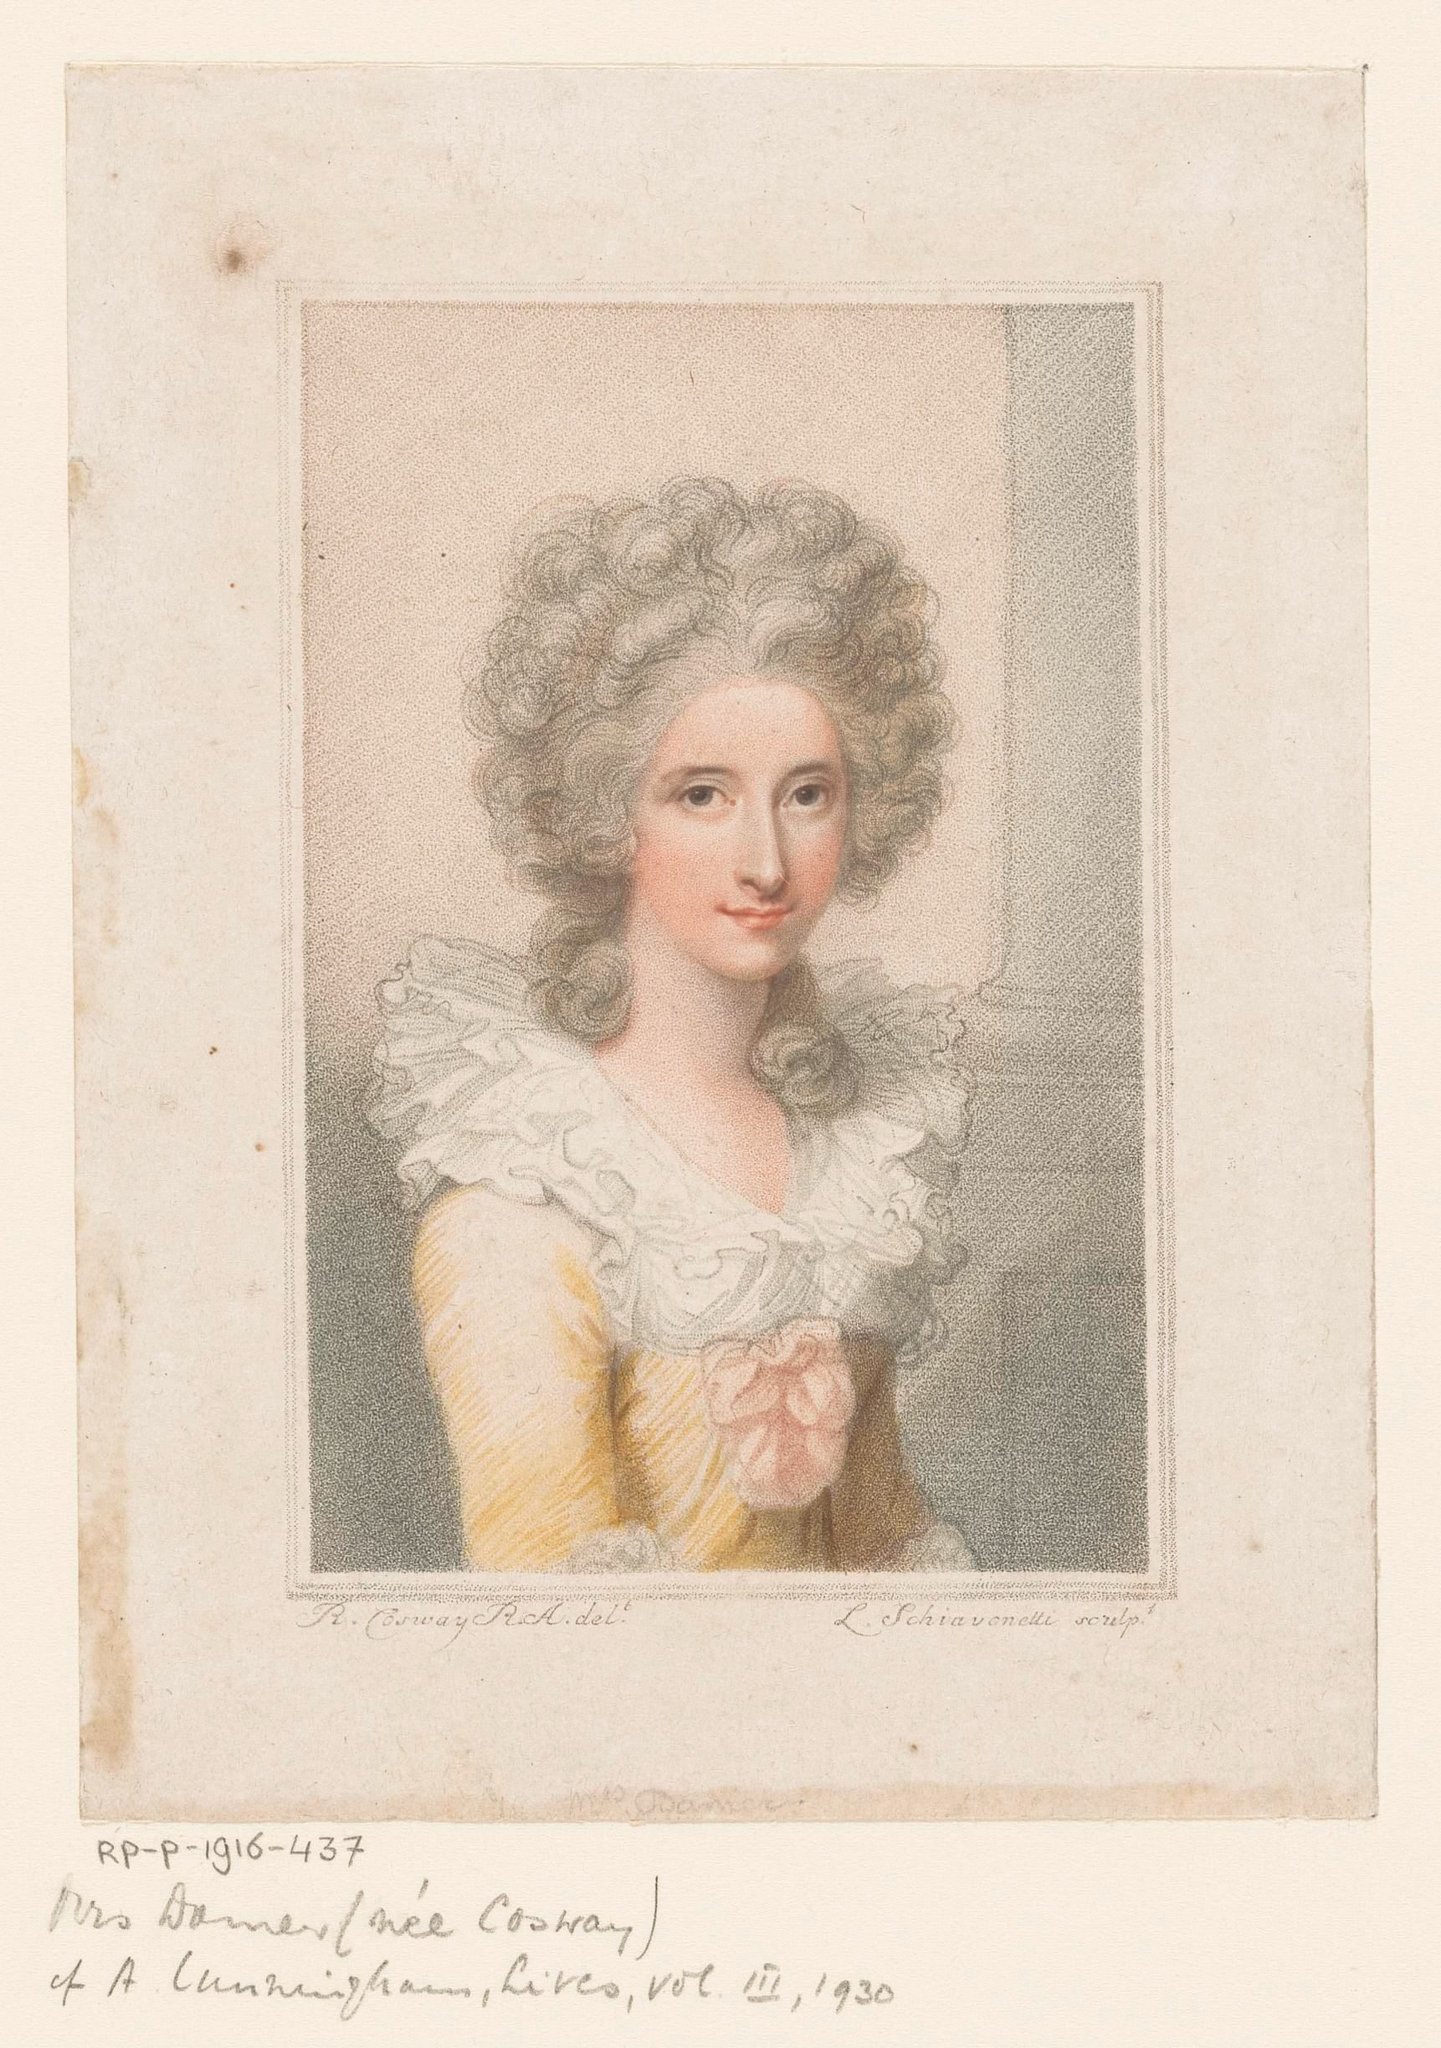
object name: print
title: Portret van beeldhouwer Anne Seymour Damer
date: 1791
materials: paper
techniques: printing, engraving, hand coloring, roulette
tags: london, anne seymour damer, historical persons, portrait, self-portrait of artist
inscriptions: collector's mark: Lugt 2233